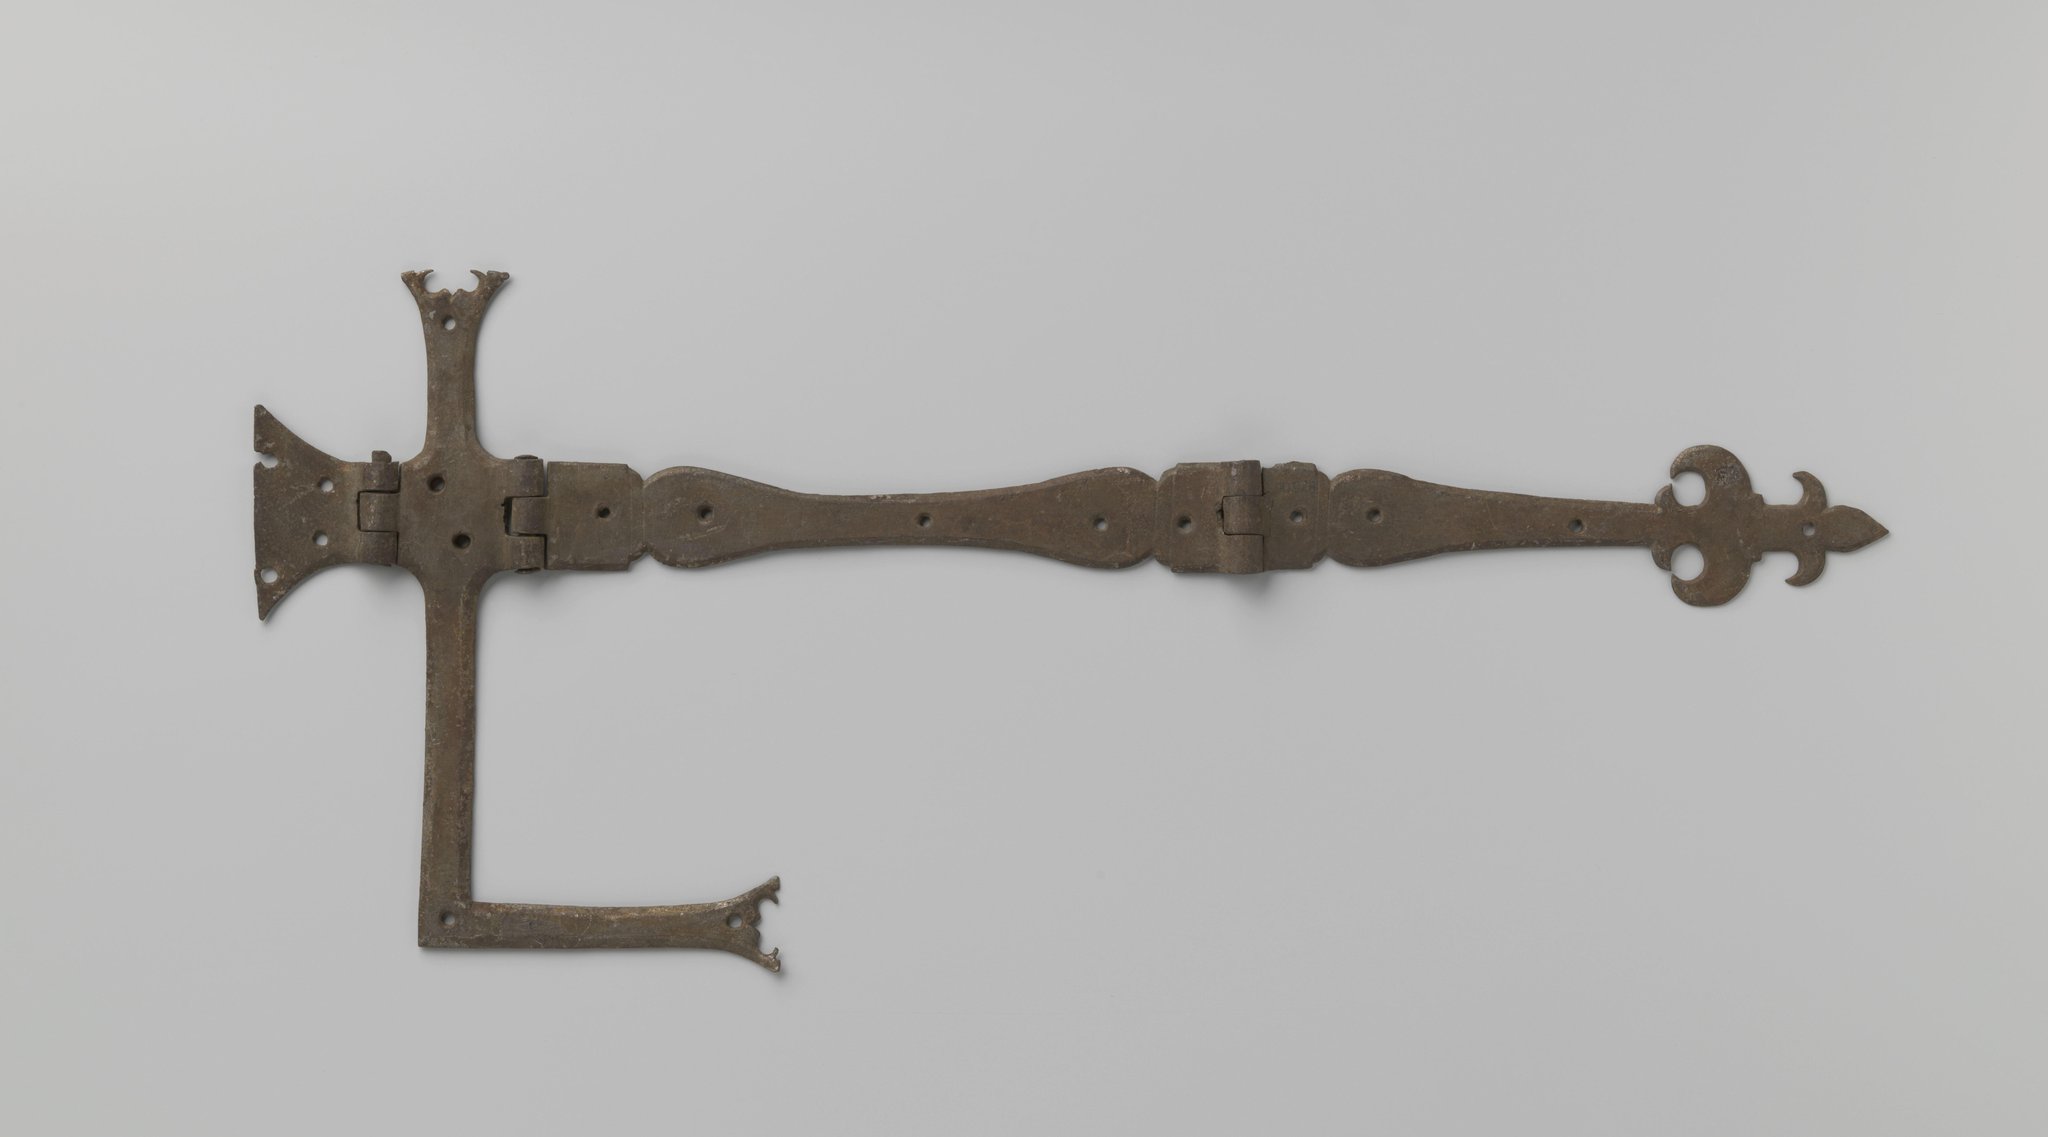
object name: knip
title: Beslag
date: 1400-1950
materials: iron